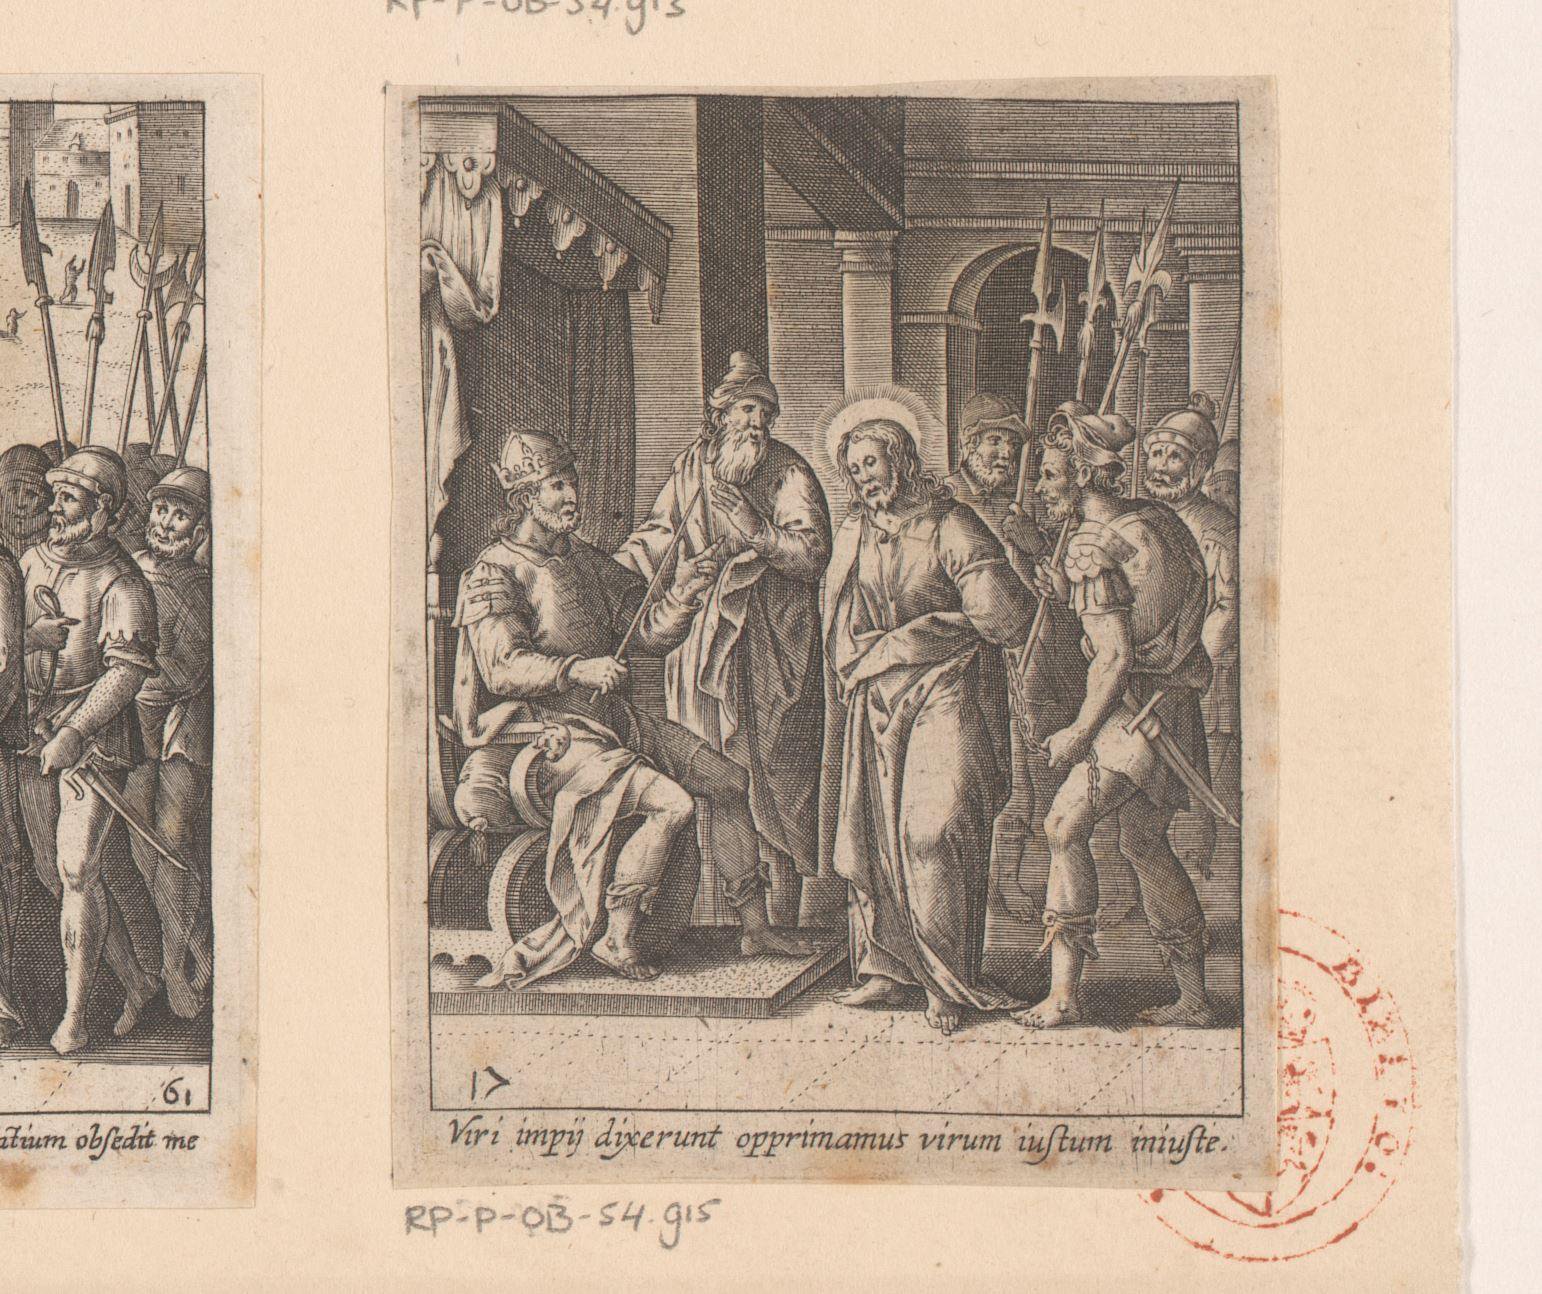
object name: print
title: Leven, passie en wederopstanding van Christus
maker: heinrich ulrich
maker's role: draughtsman, painter, print maker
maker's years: 1572-1671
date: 1582-1671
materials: paper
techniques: engraving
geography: germany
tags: christ before king herod; sometimes a gorgeous robe is brought (luke 23:8-11)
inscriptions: number: ‘38. - 64.’, collector's mark: Lugt 240